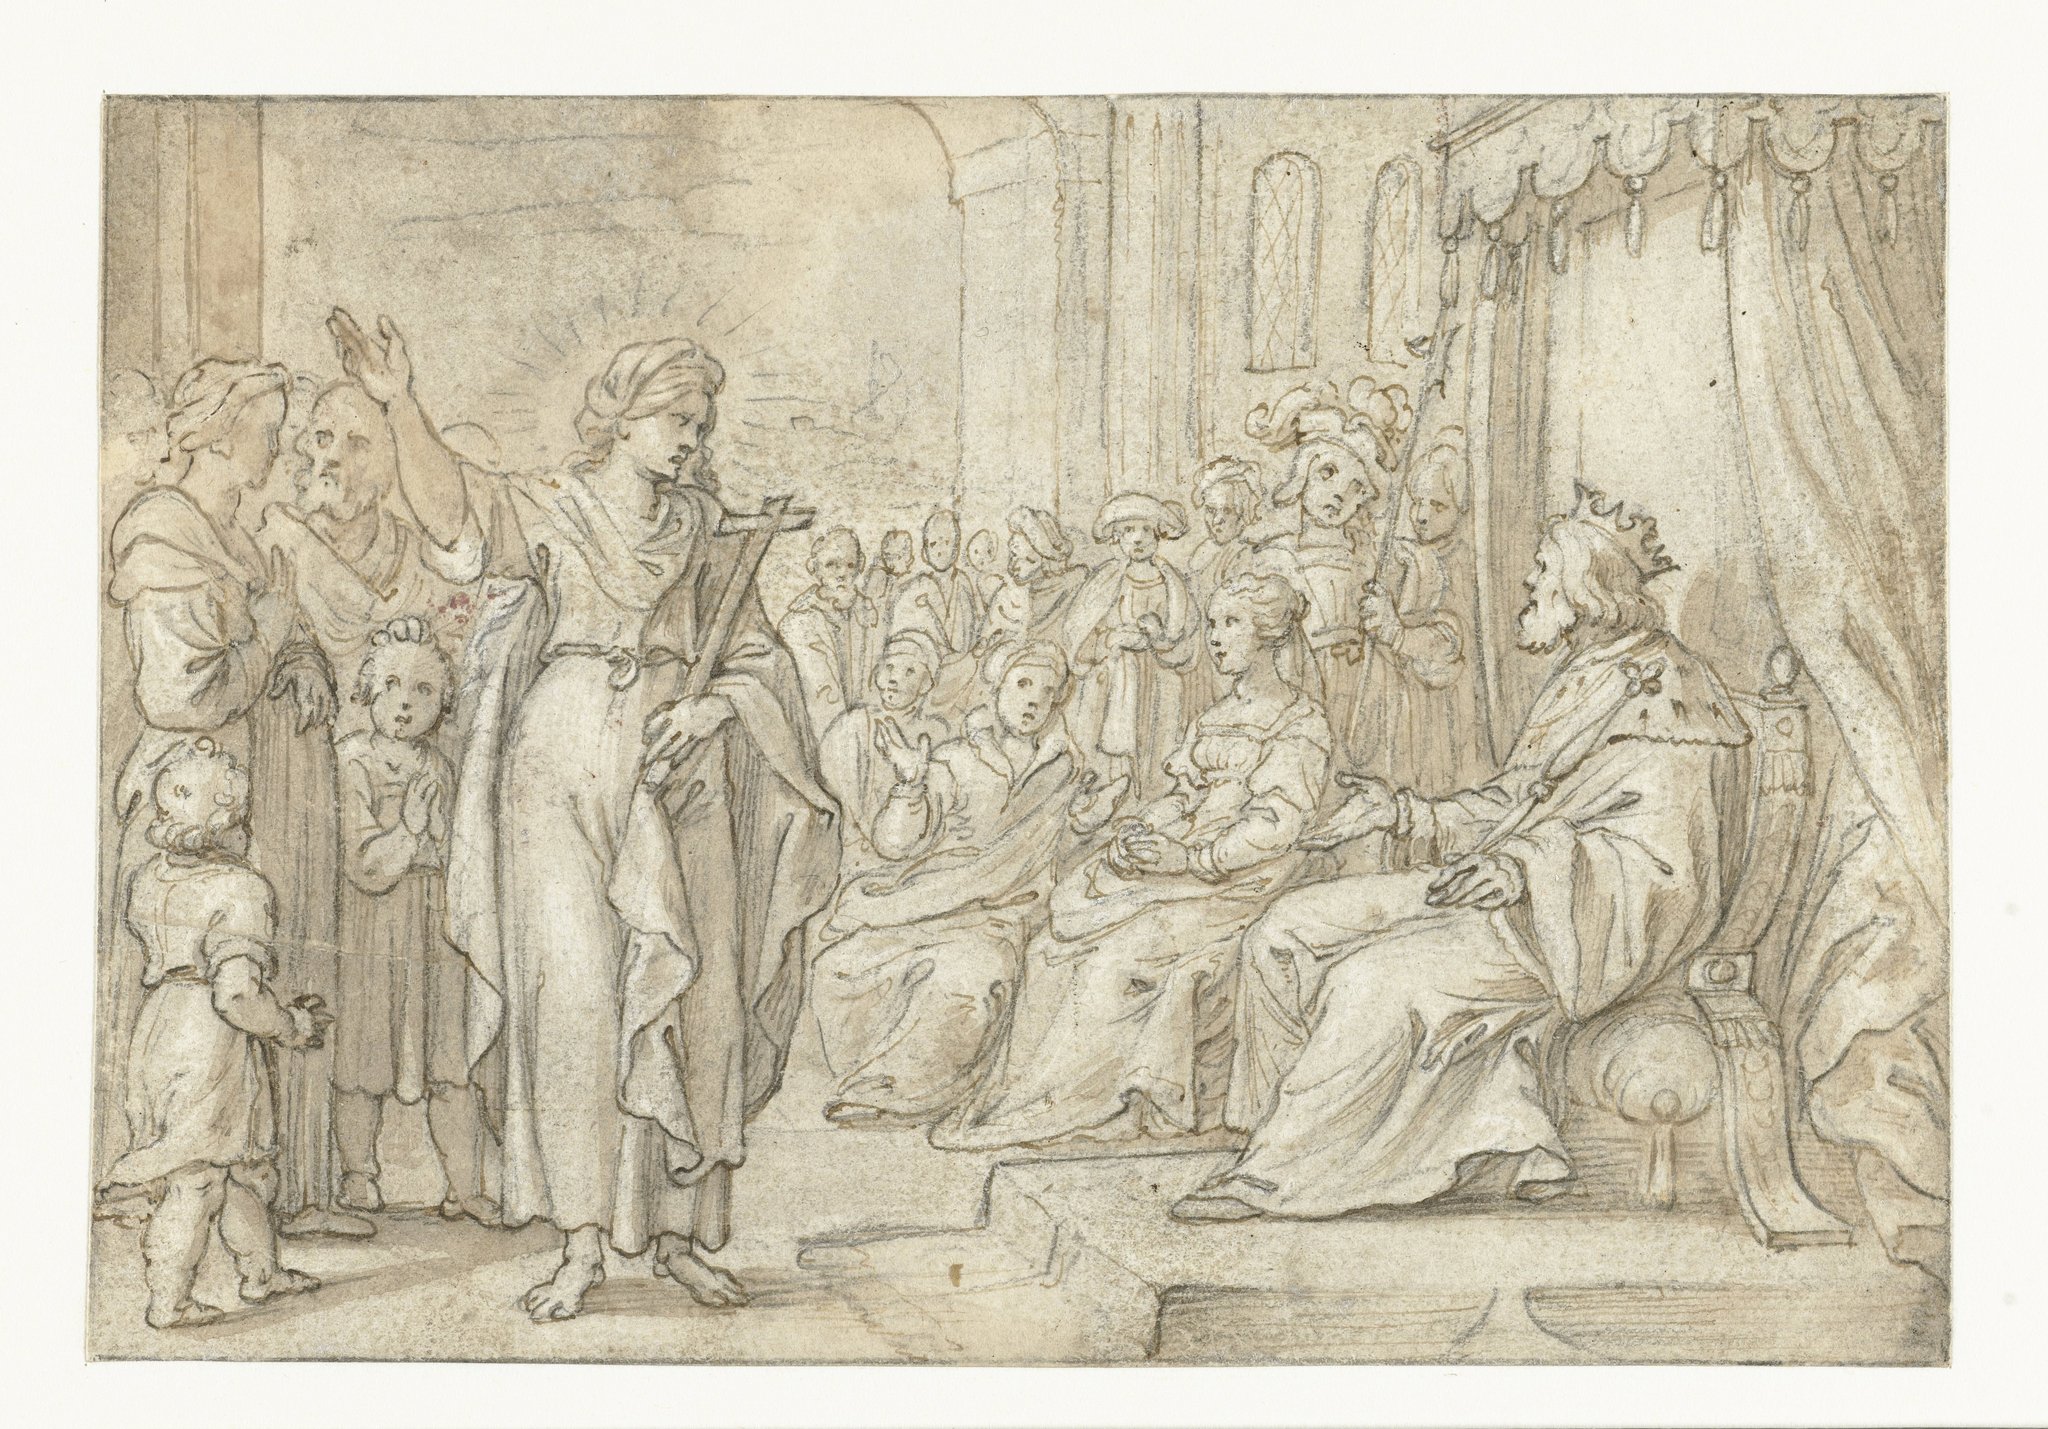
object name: drawing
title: Vrouwelijke heilige verschijnt voor een koning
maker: pieter de jode (i)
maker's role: draughtsman, print maker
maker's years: 1570-1634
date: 1580-1634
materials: chalk, ink, paper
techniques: brush, pen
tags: throne-room, official acts of rulers, e.g. royal acts (ruler giving audience, granting mercy, etc.; ruler and his subjects), female saints, king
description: Vrouwelijke heilige verschijnt voor een koning en zijn hof.